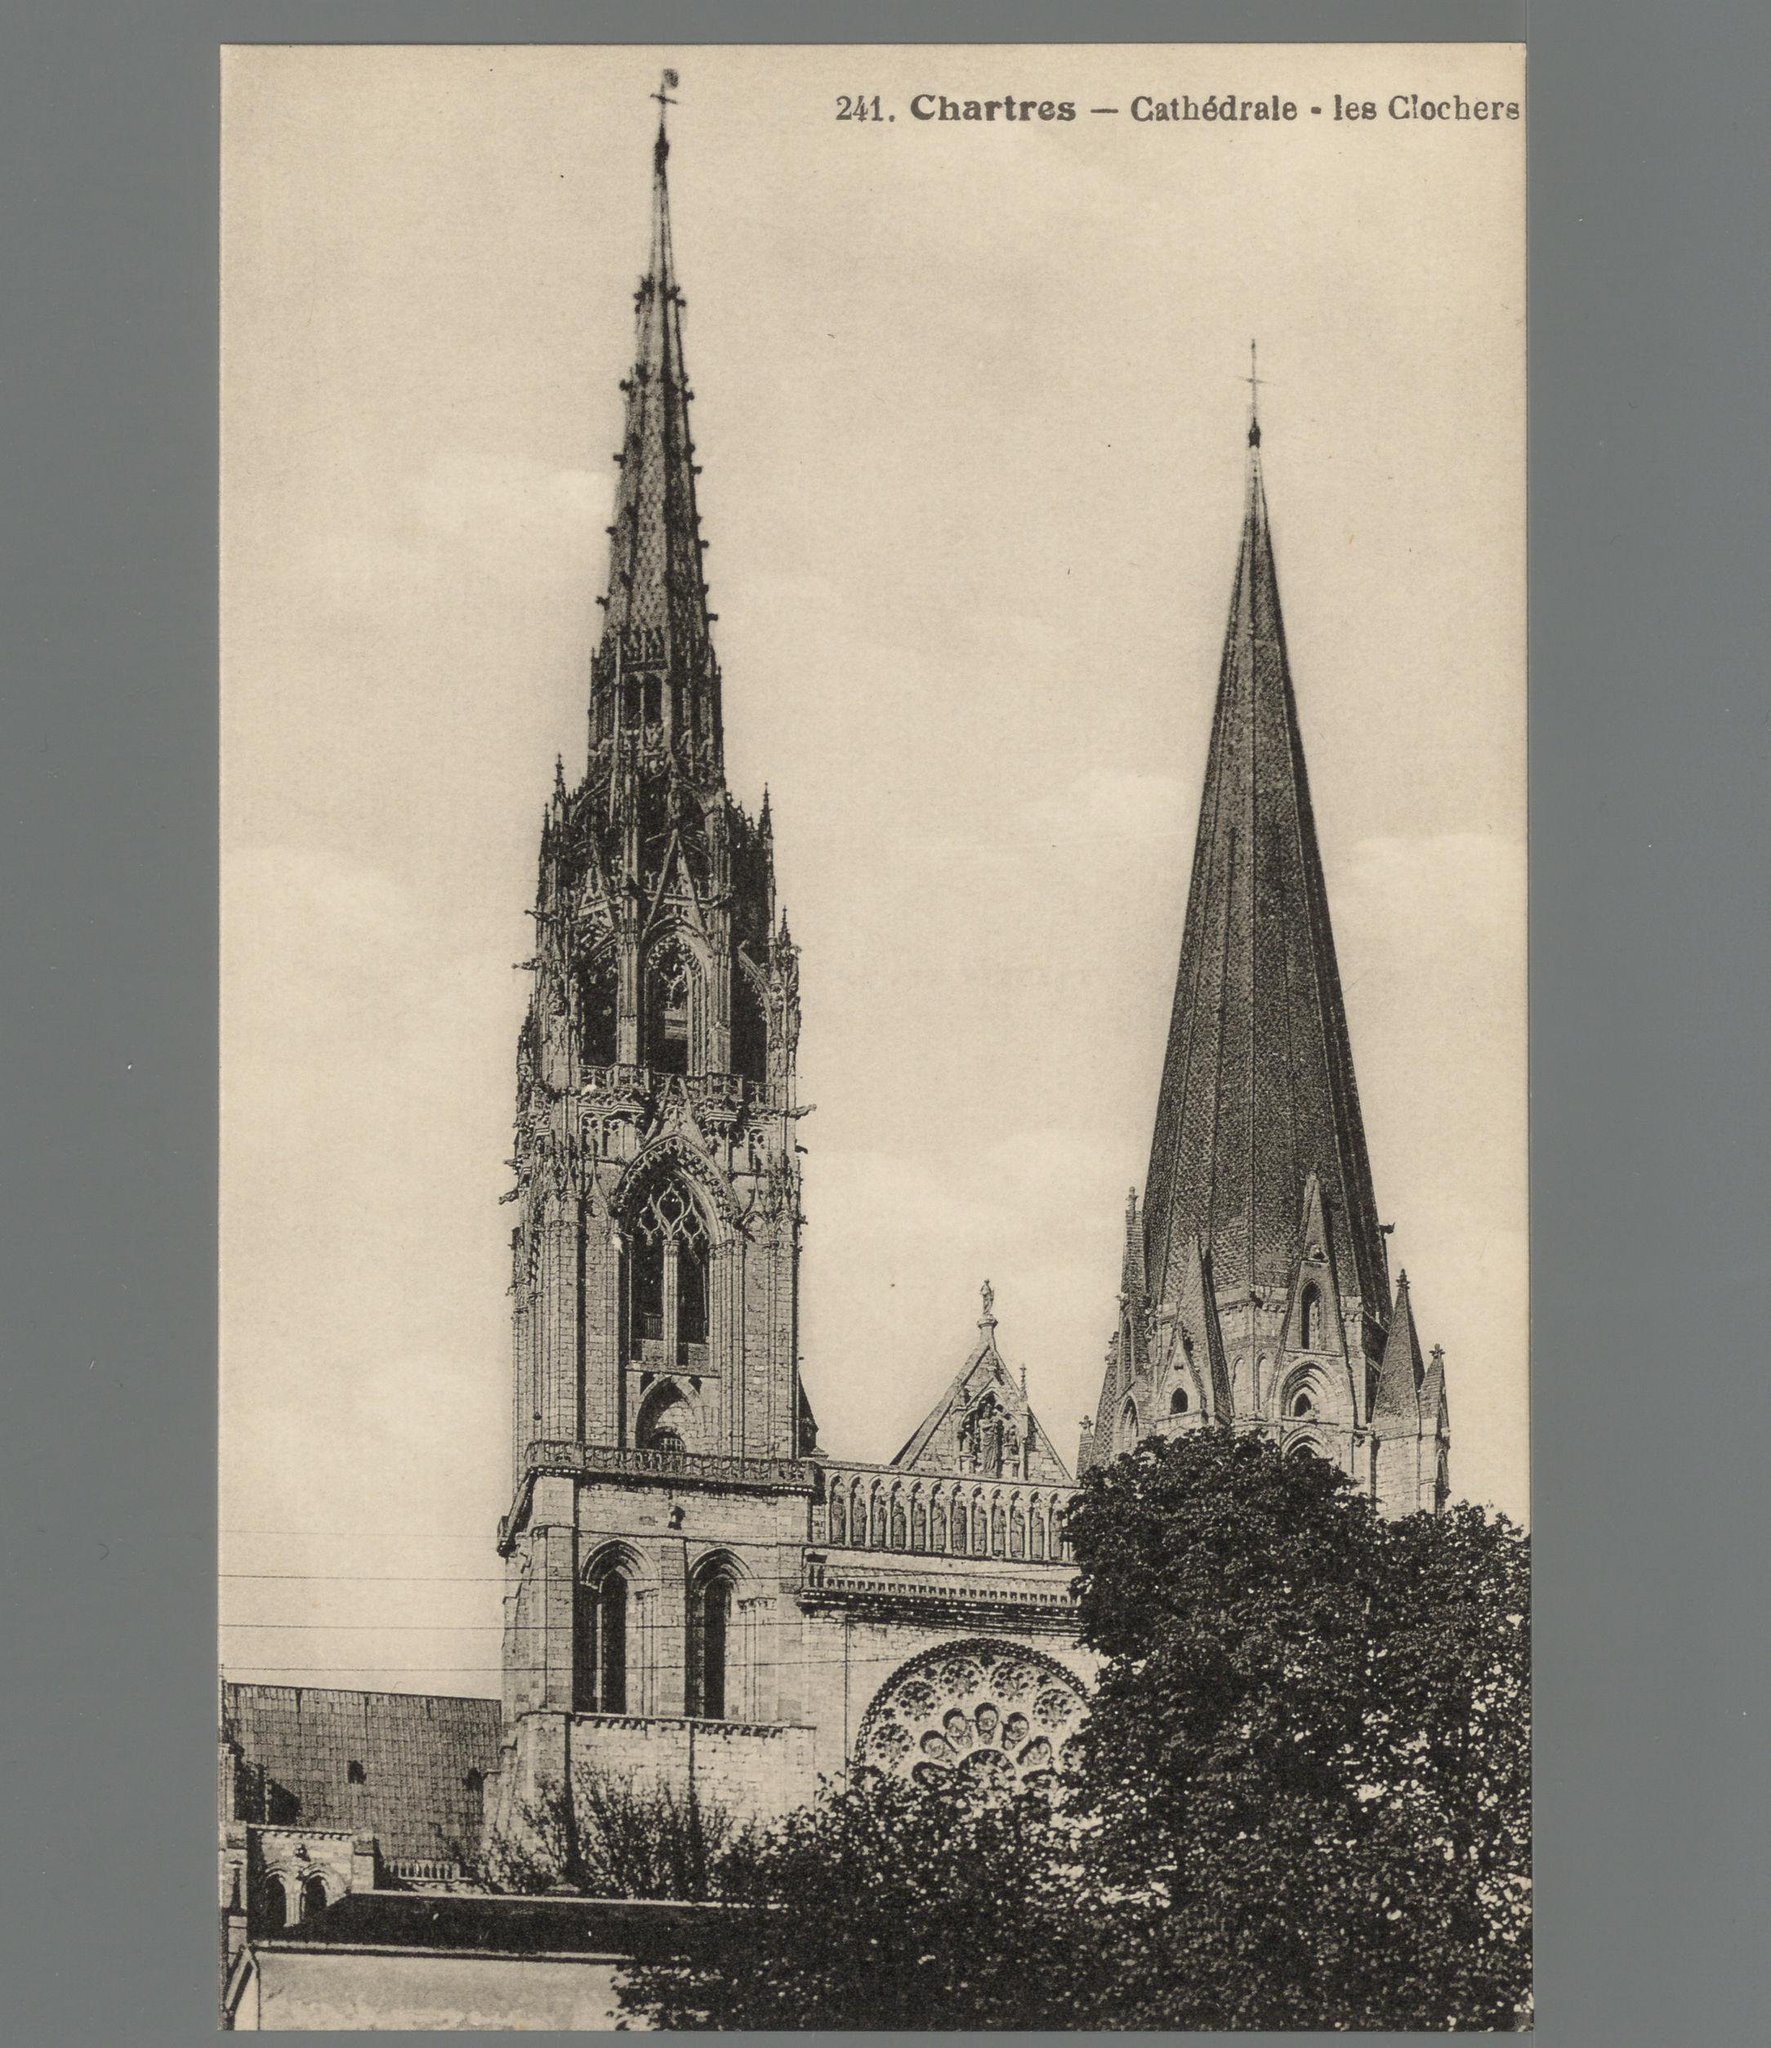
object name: ansichtkaart, prentbriefkaart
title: Chartres - Cathédrale - Les Clochers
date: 1903-1930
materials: cardboard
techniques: photograph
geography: chartres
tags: parts of church exterior and annexes: tower